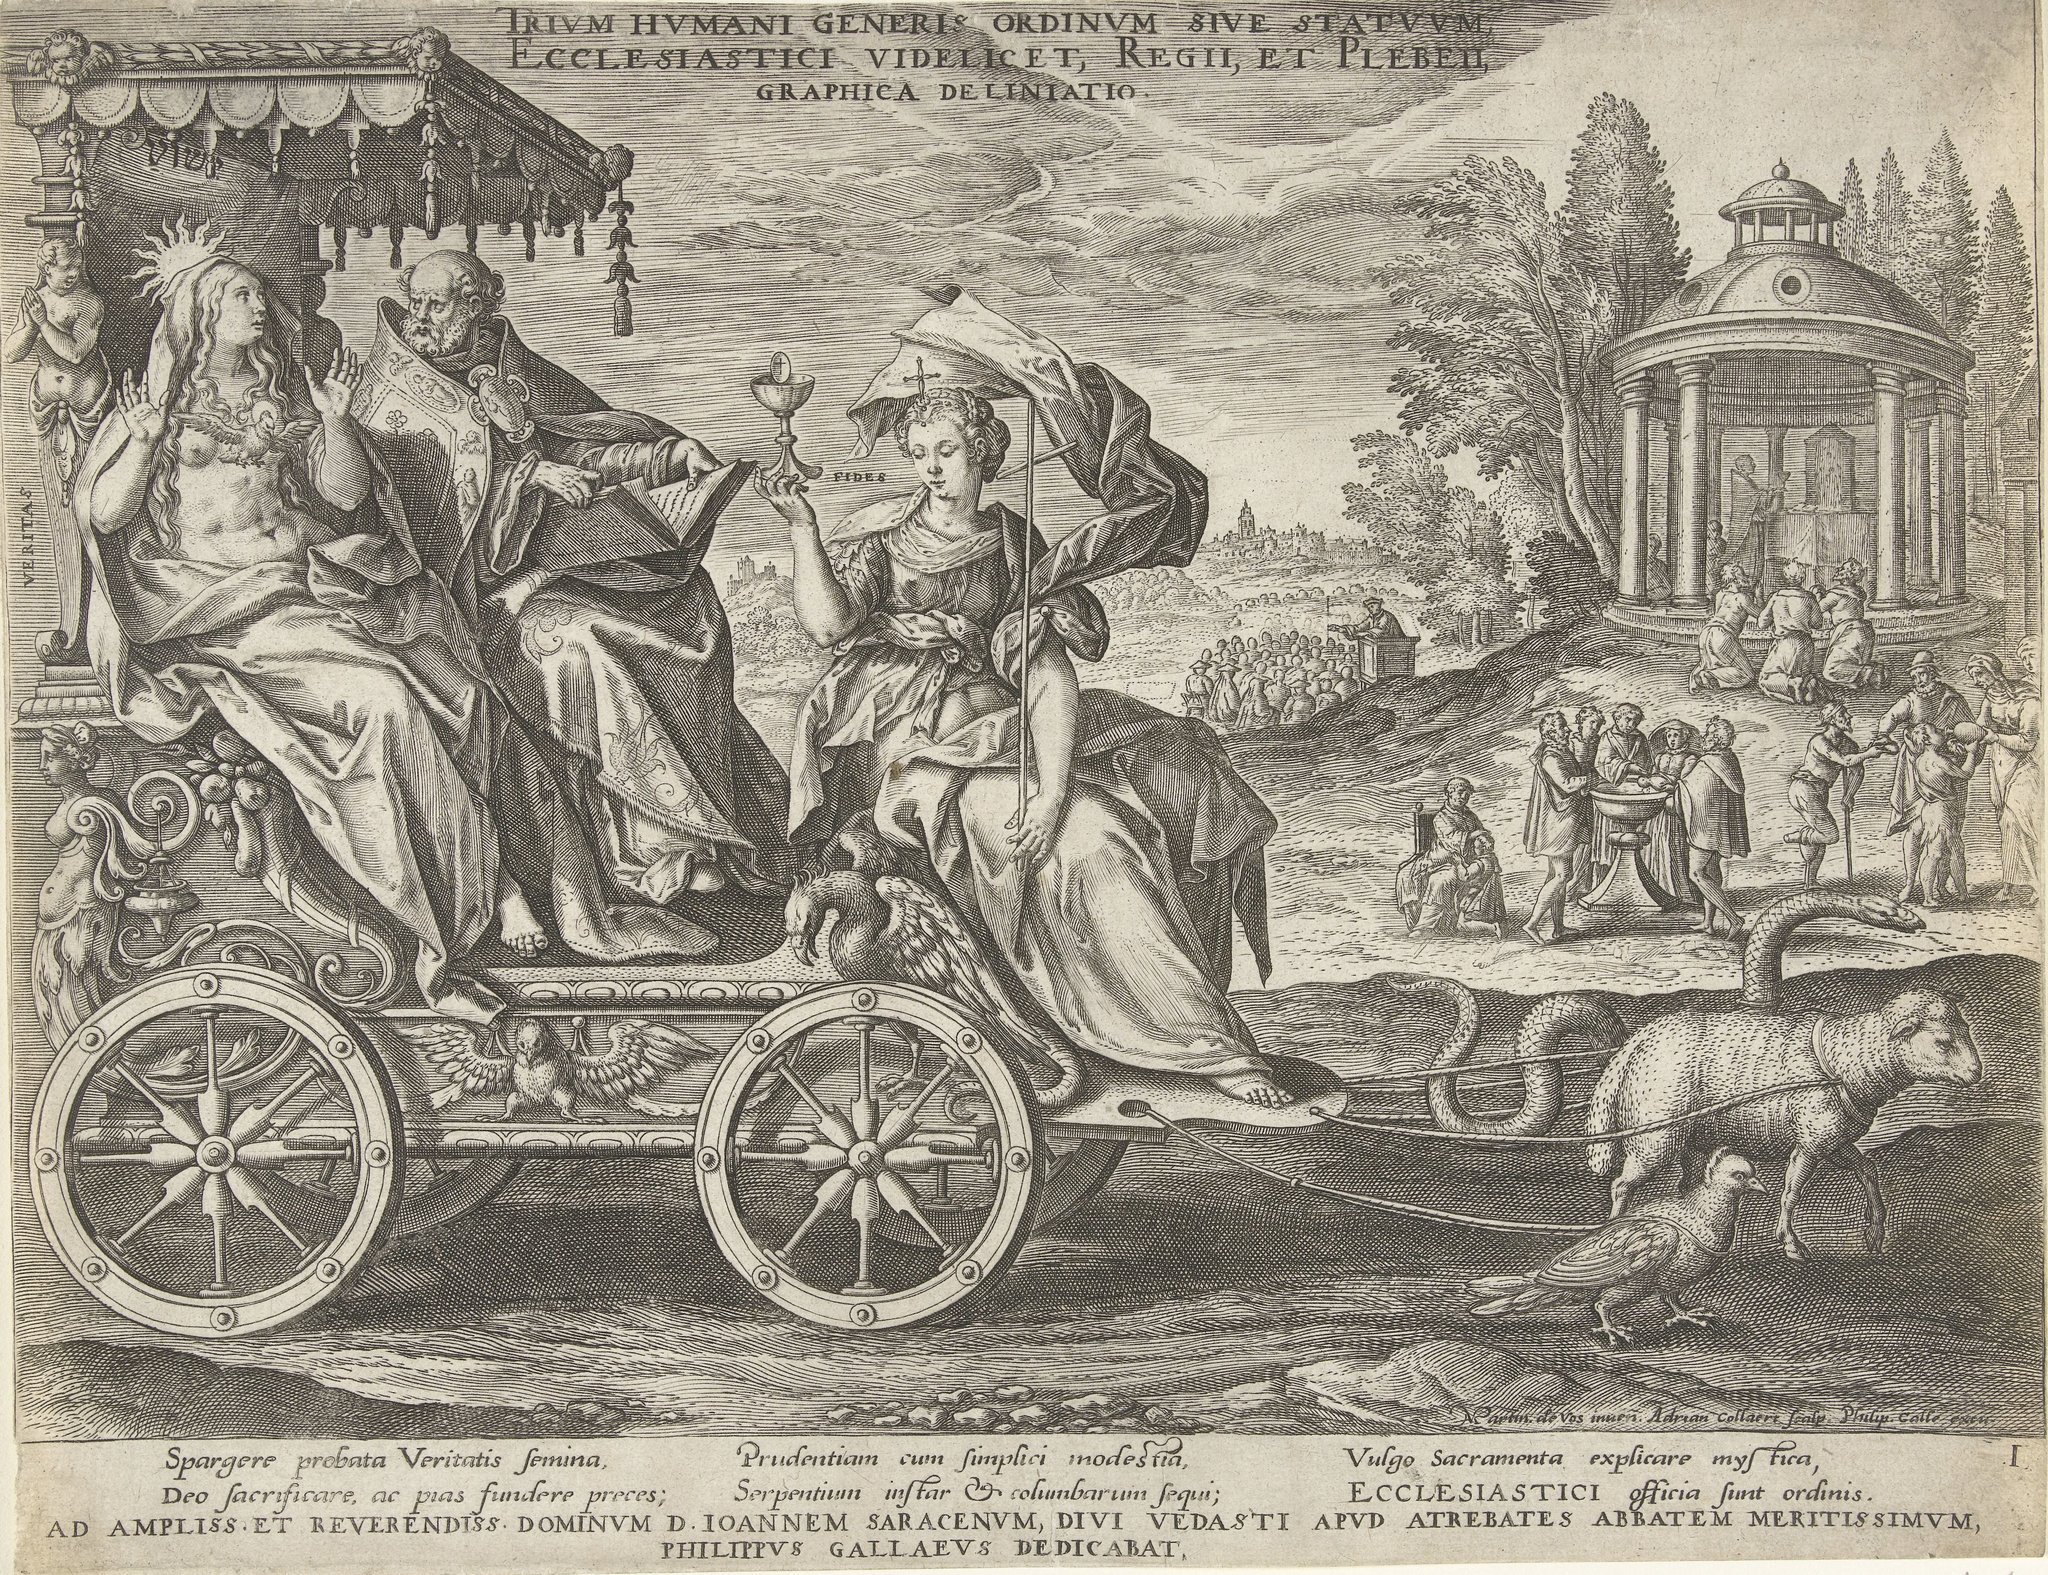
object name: print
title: Trium Humani generis ordinum sive statuum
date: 1583-1588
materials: paper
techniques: engraving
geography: antwerp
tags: faith, 'fides'; 'fede', 'fede catholica', 'fede christiana', 'fede christiana catholica' (ripa) ~ one of the three theological virtues, the eucharist ~ the fourth of the seven sacraments, truth; 'verità' (ripa), confession; 'confessione sacramentale' (ripa) ~ the third of the seven sacraments, preaching (in general), organization, functionaries and dignitaries in roman catholic church; clergy in general, charitable works, baptism, christening ceremony ~ the first of the seven sacraments - qq - baptism in the open air, triumphs (allegorical and symbolic) (+ decorated float, wagon ~ festive activities), the three estates: nobility, clergy, commoners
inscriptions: collector's mark: Lugt 2228, collector's mark: Lugt 2760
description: Een triomfwagen met de vertegenwoordiger van de kerkelijke macht, de Paus. Naast hem zit de allegorische figuur van Waarheid. De triomfwagen wordt getrokken door een schaap (het Lam Gods), een slang (de Voorzienigheid) en een duif (De Heilige Geest) en bestuurd door de allegorische figuur van Geloof. Op de achtergrond enkele taken van de geestelijkheid: de doop, de liefdadigheid, de biecht, de eucharistie en de preek. De prent heeft een Latijnse opschrift en een Latijns onderschrift en is deel van een vierdelige serie over de goddelijke taken van de drie standen.